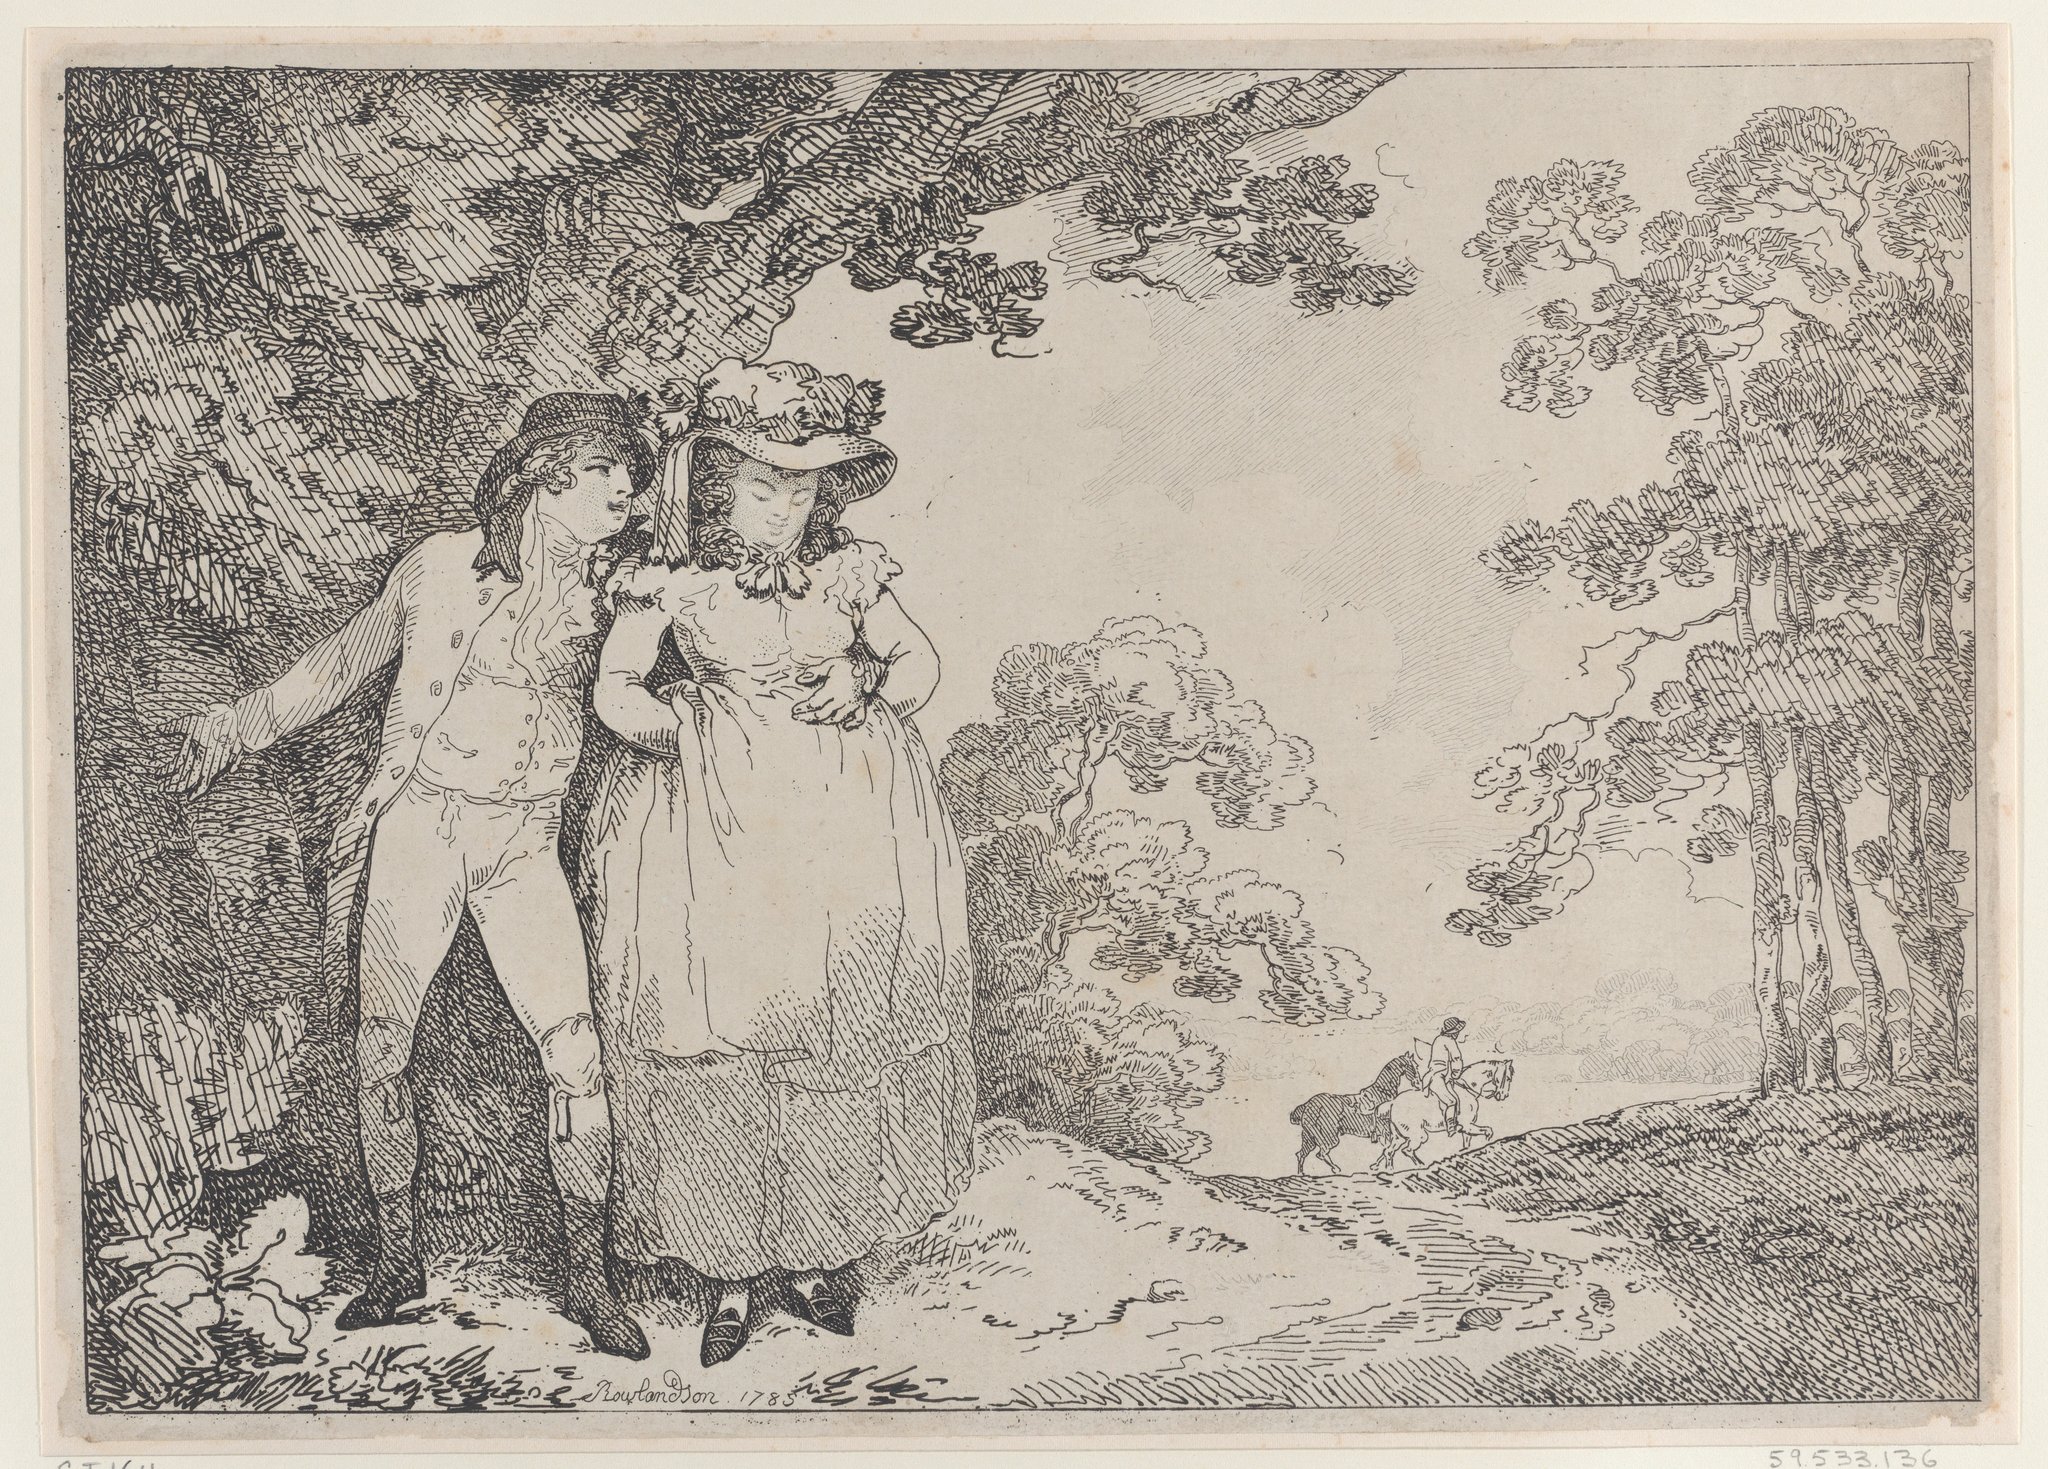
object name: print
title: Going, A-Going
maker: thomas rowlandson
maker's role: artist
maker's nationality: british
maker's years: 1757-1827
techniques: etching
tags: couples,men,women